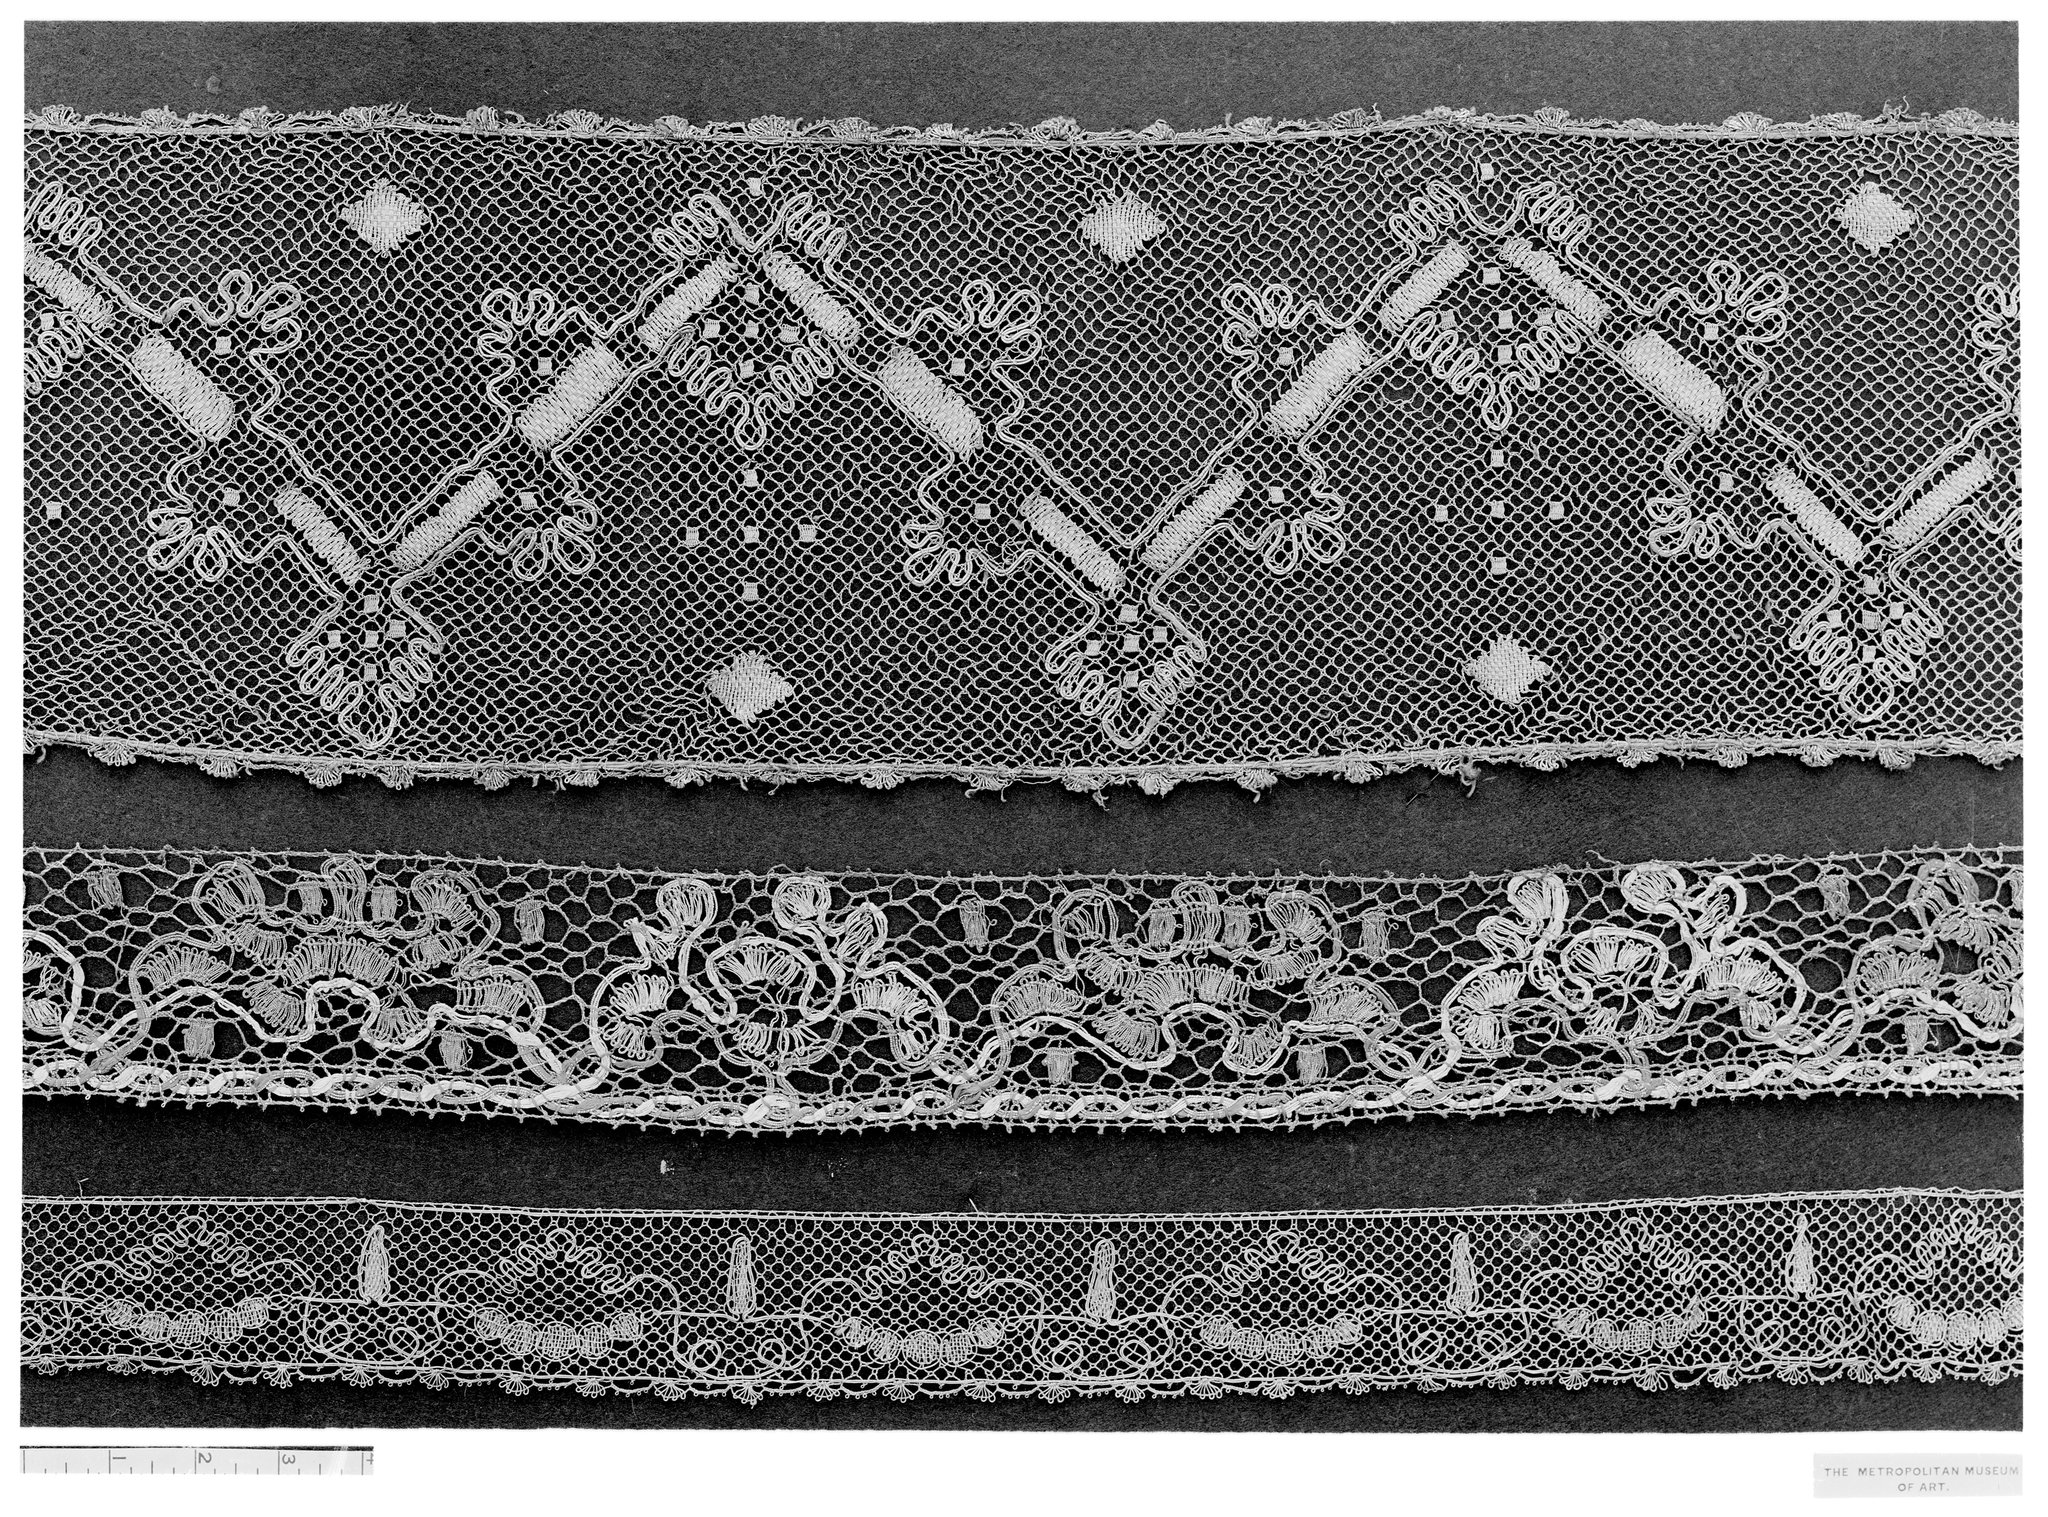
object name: strip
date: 1734-1766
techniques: lace